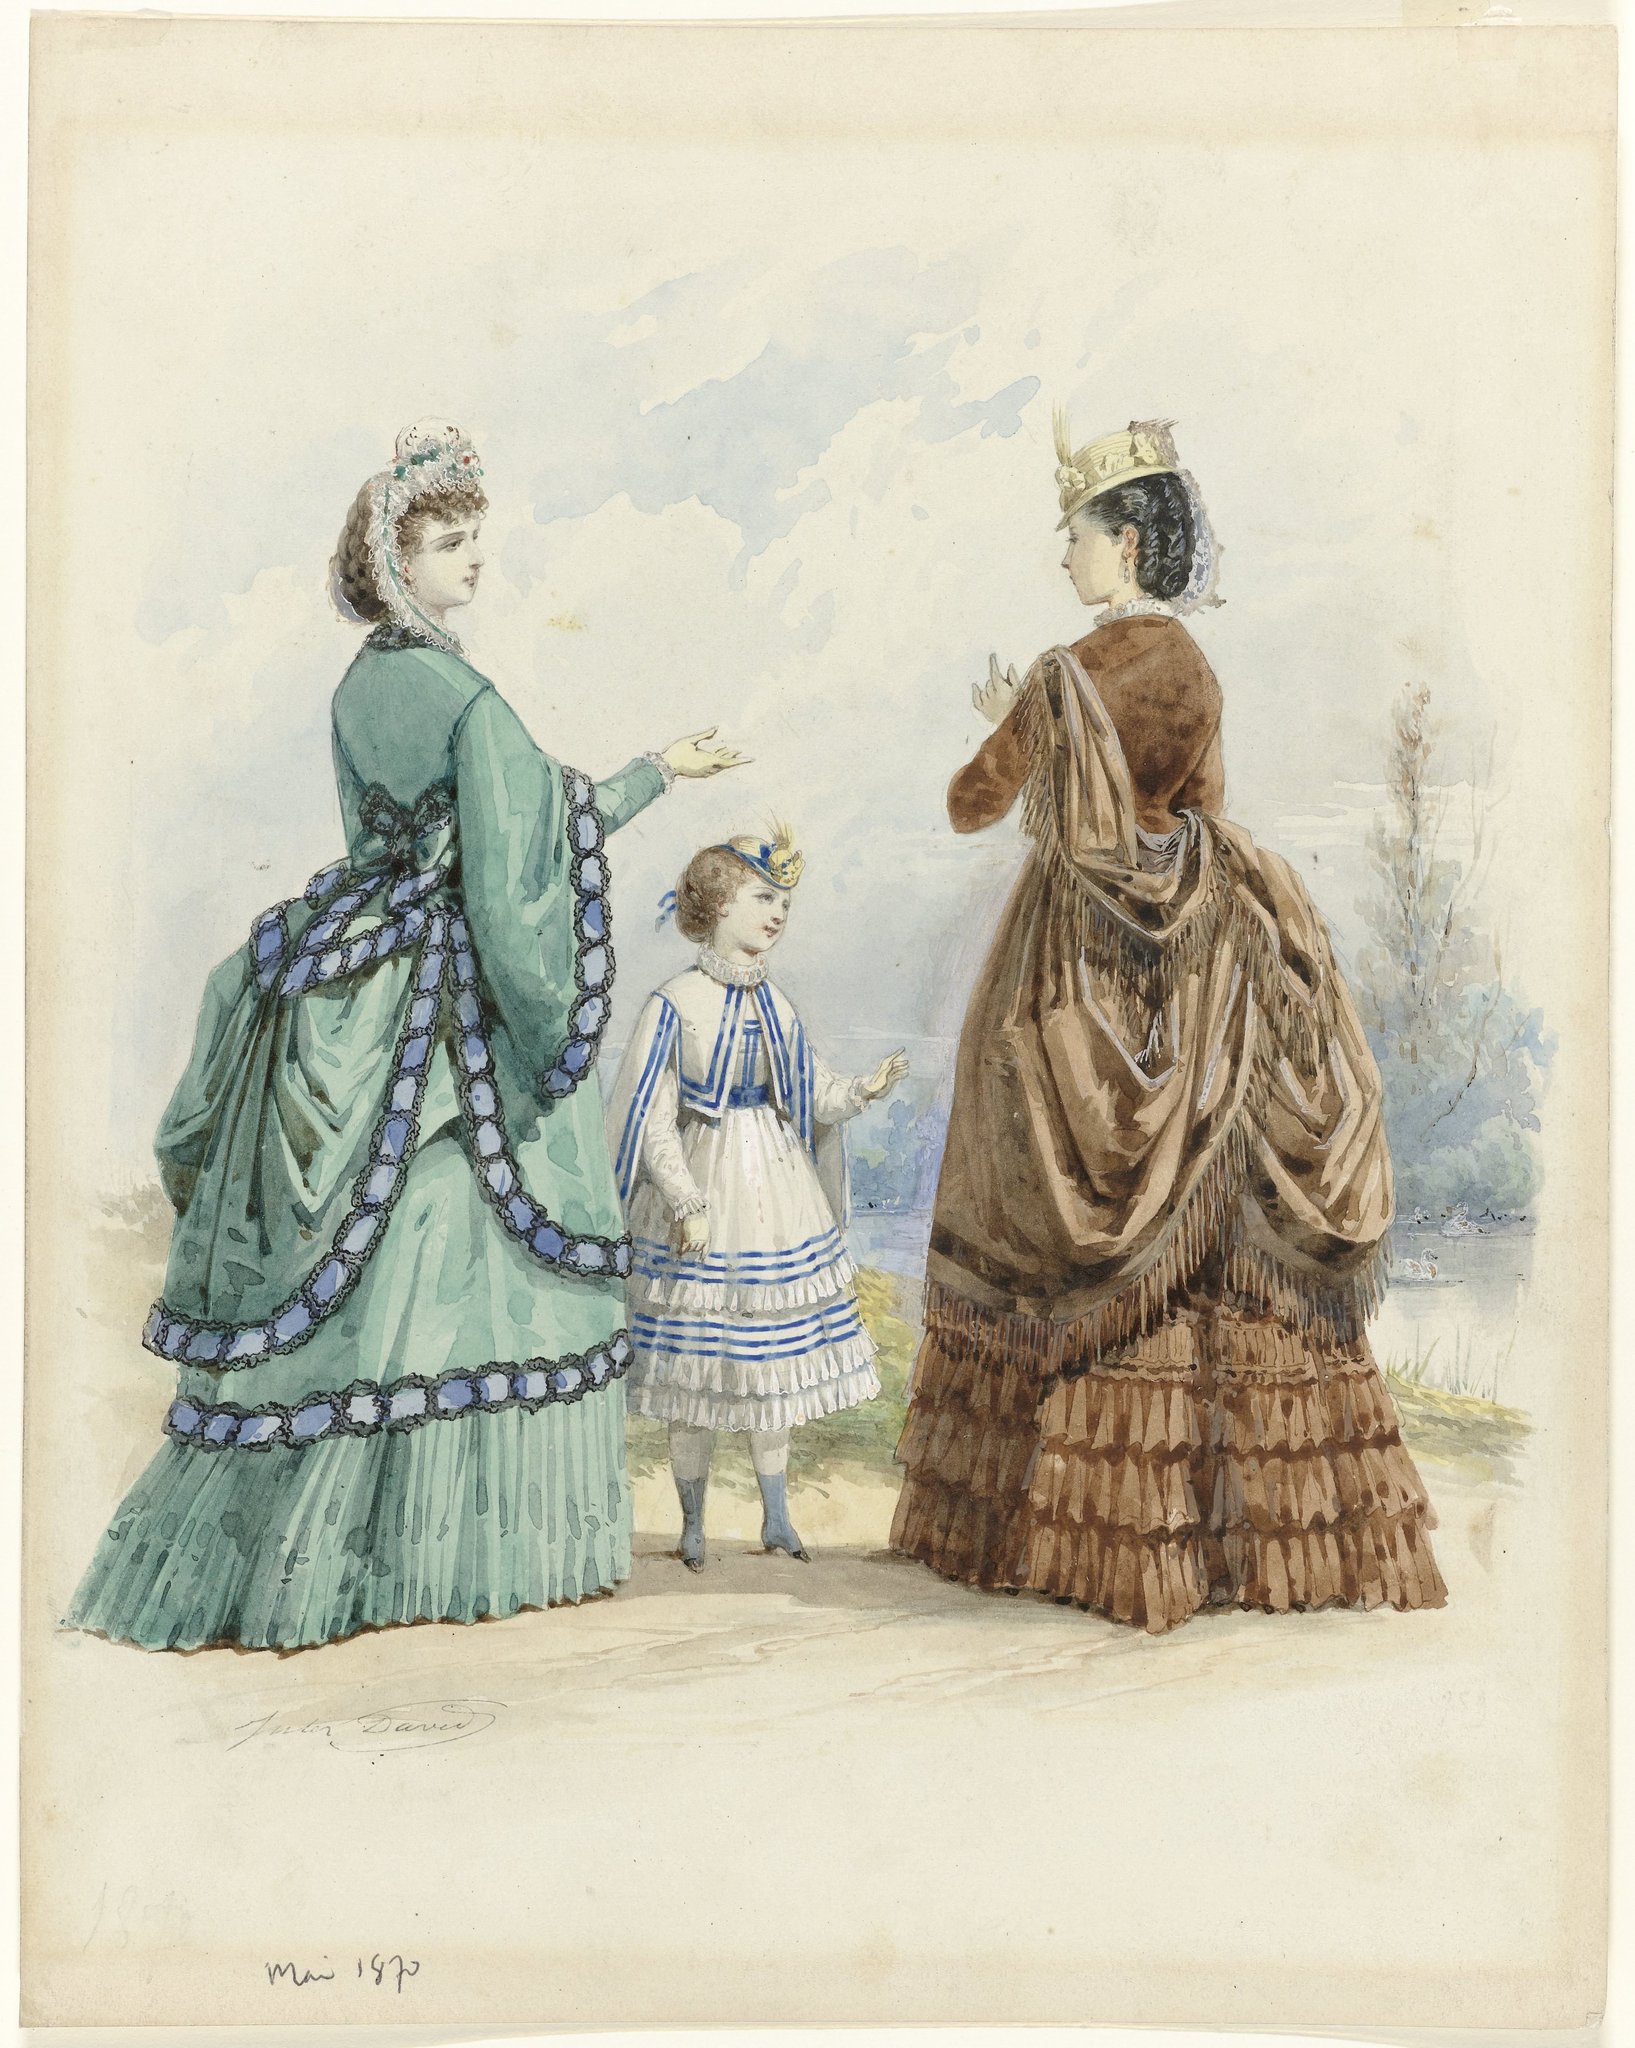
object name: drawing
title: Twee vrouwen en een meisje, Mai 1870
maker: jules david (1808-1892)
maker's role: draughtsman, painter, print maker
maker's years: 1808-1892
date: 1805-1870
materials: paper, pencil, watercolor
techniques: brush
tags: fashion plates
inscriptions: date